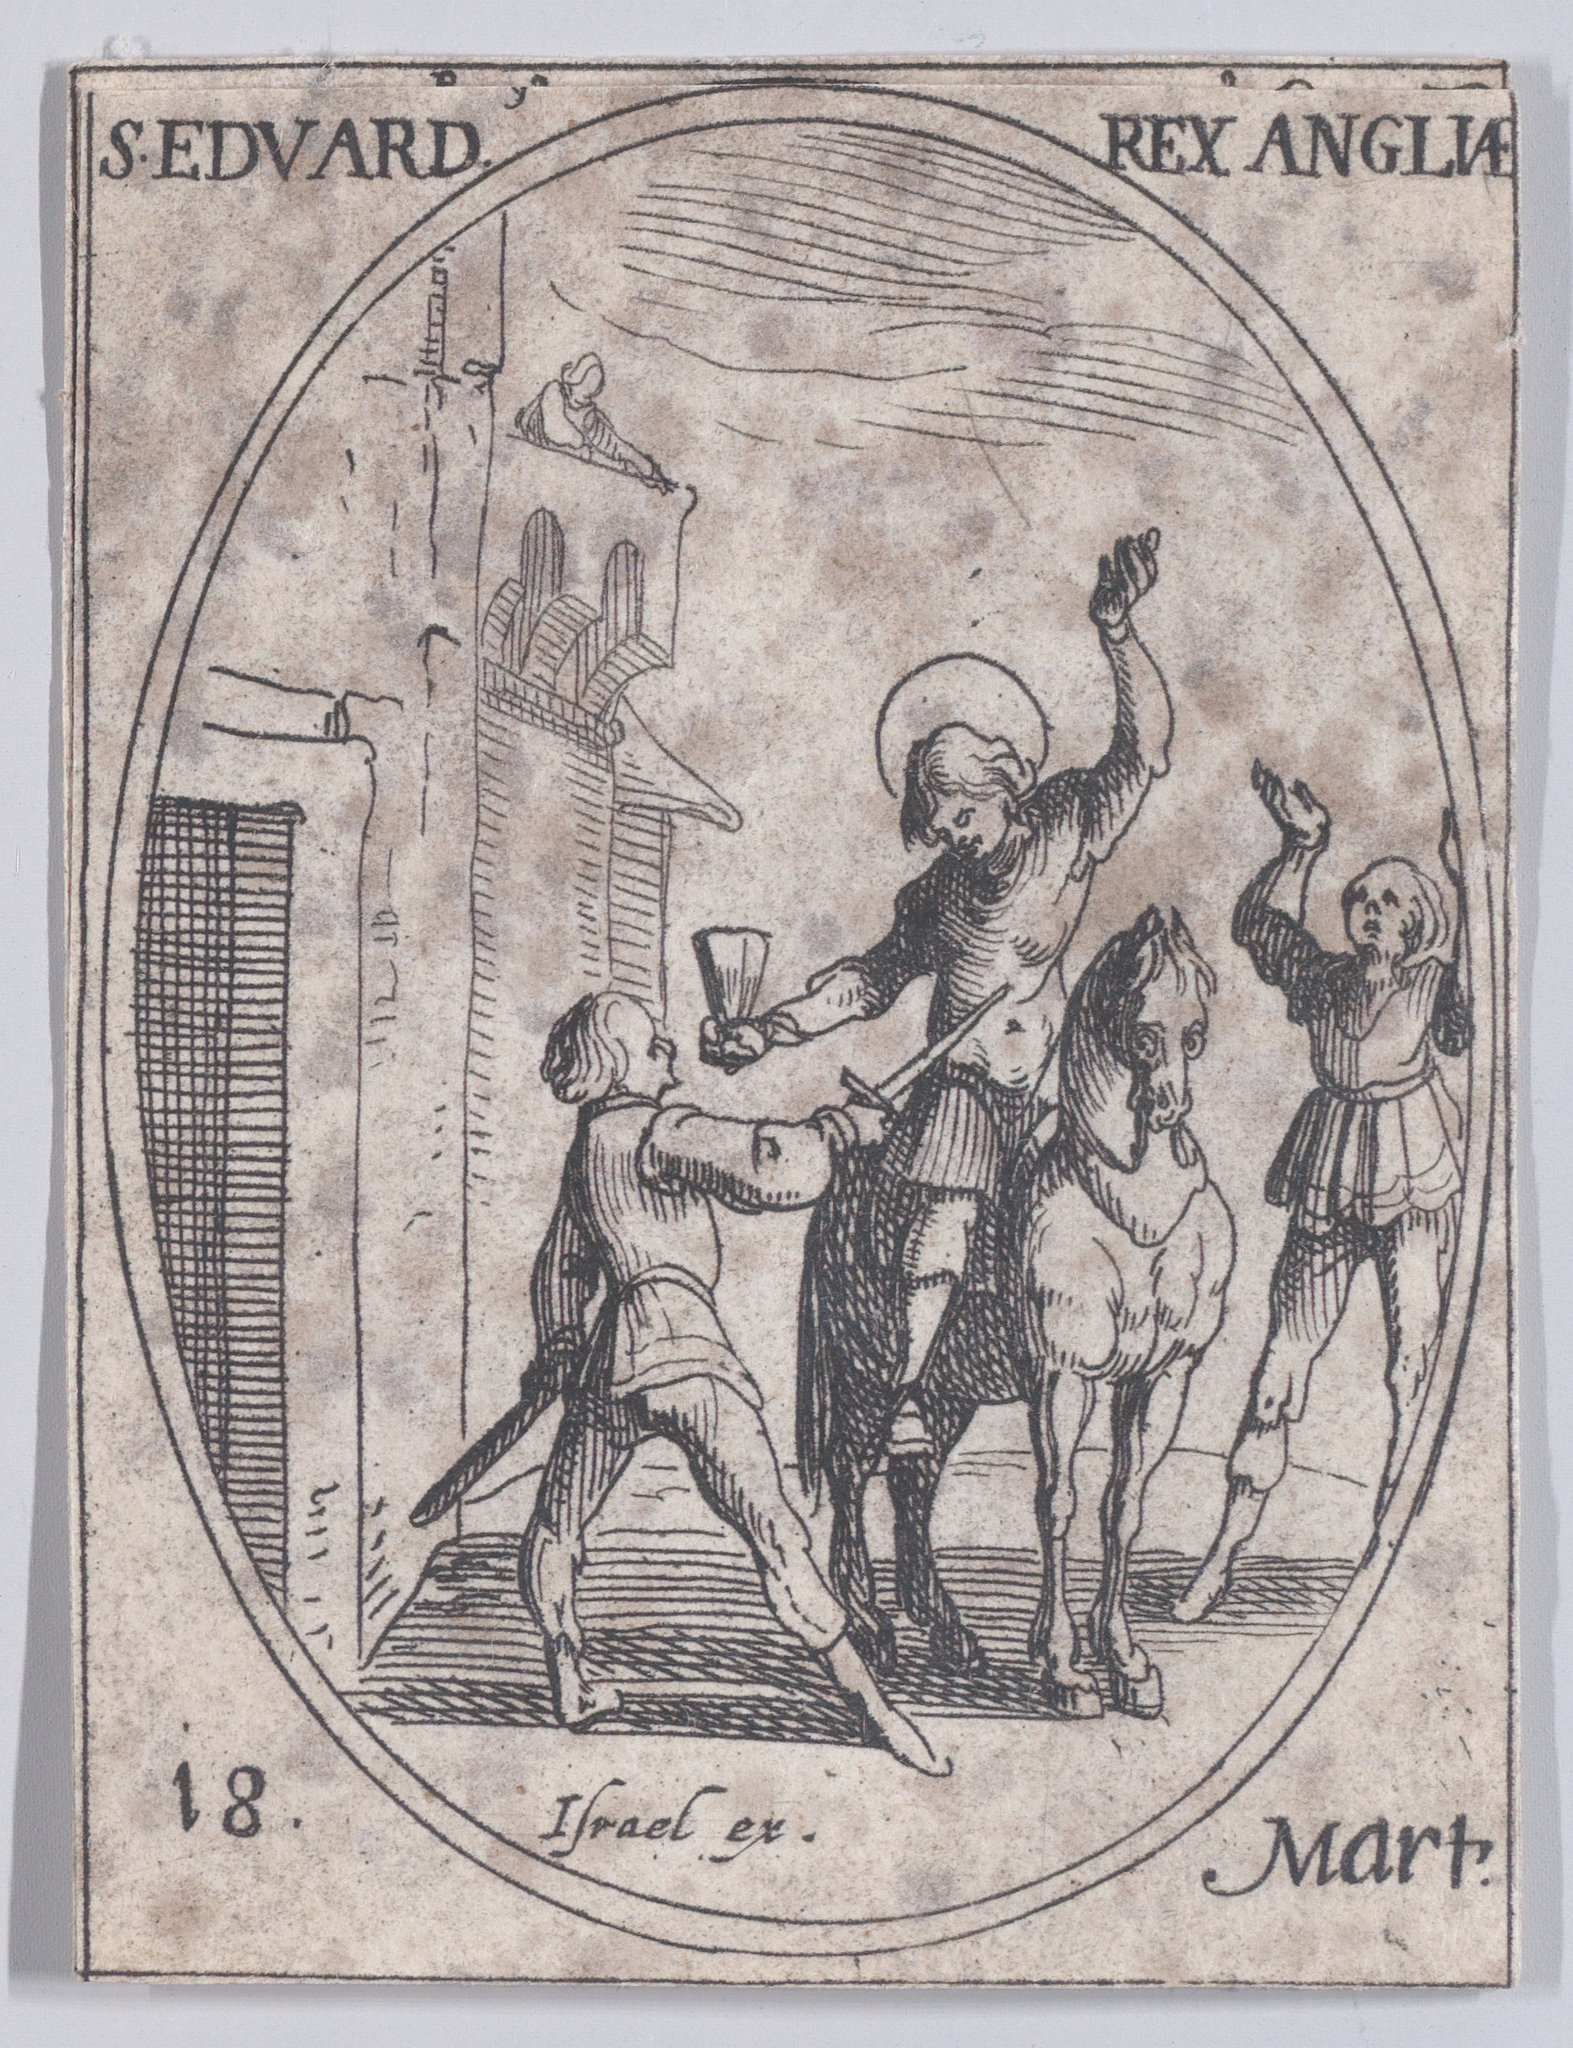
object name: print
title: S. Edouard, roi d'Angleterre (St. Edward, King of England), March 18th, from "Les Images De Tous Les Saincts et Saintes de L'Année" (Images of All of the Saints and Religious Events of the Year)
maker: jacques callot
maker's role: artist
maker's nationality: french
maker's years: 1592-1635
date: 1636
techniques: etching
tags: men,horses,saints